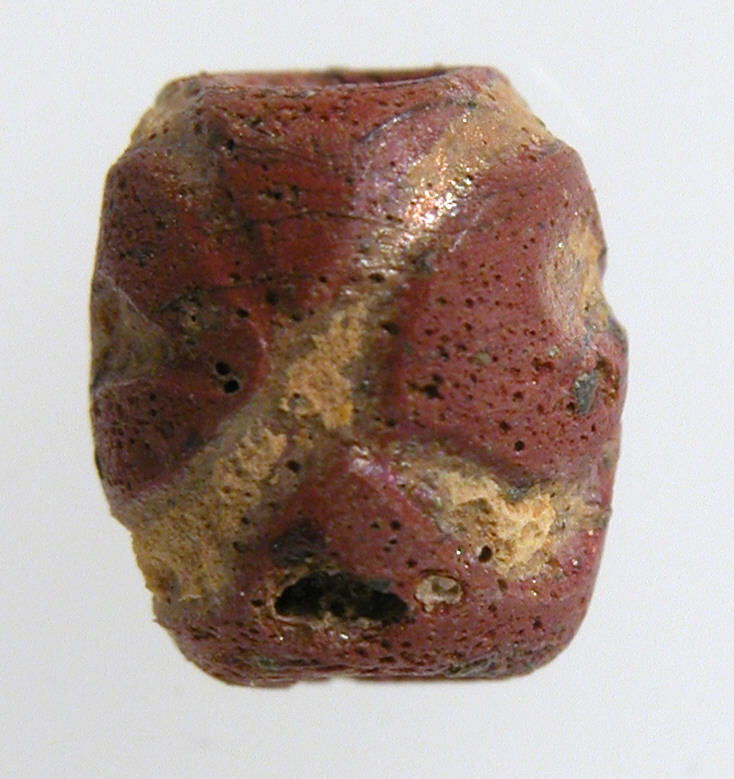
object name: bead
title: Small Bead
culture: frankish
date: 500-600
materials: glass